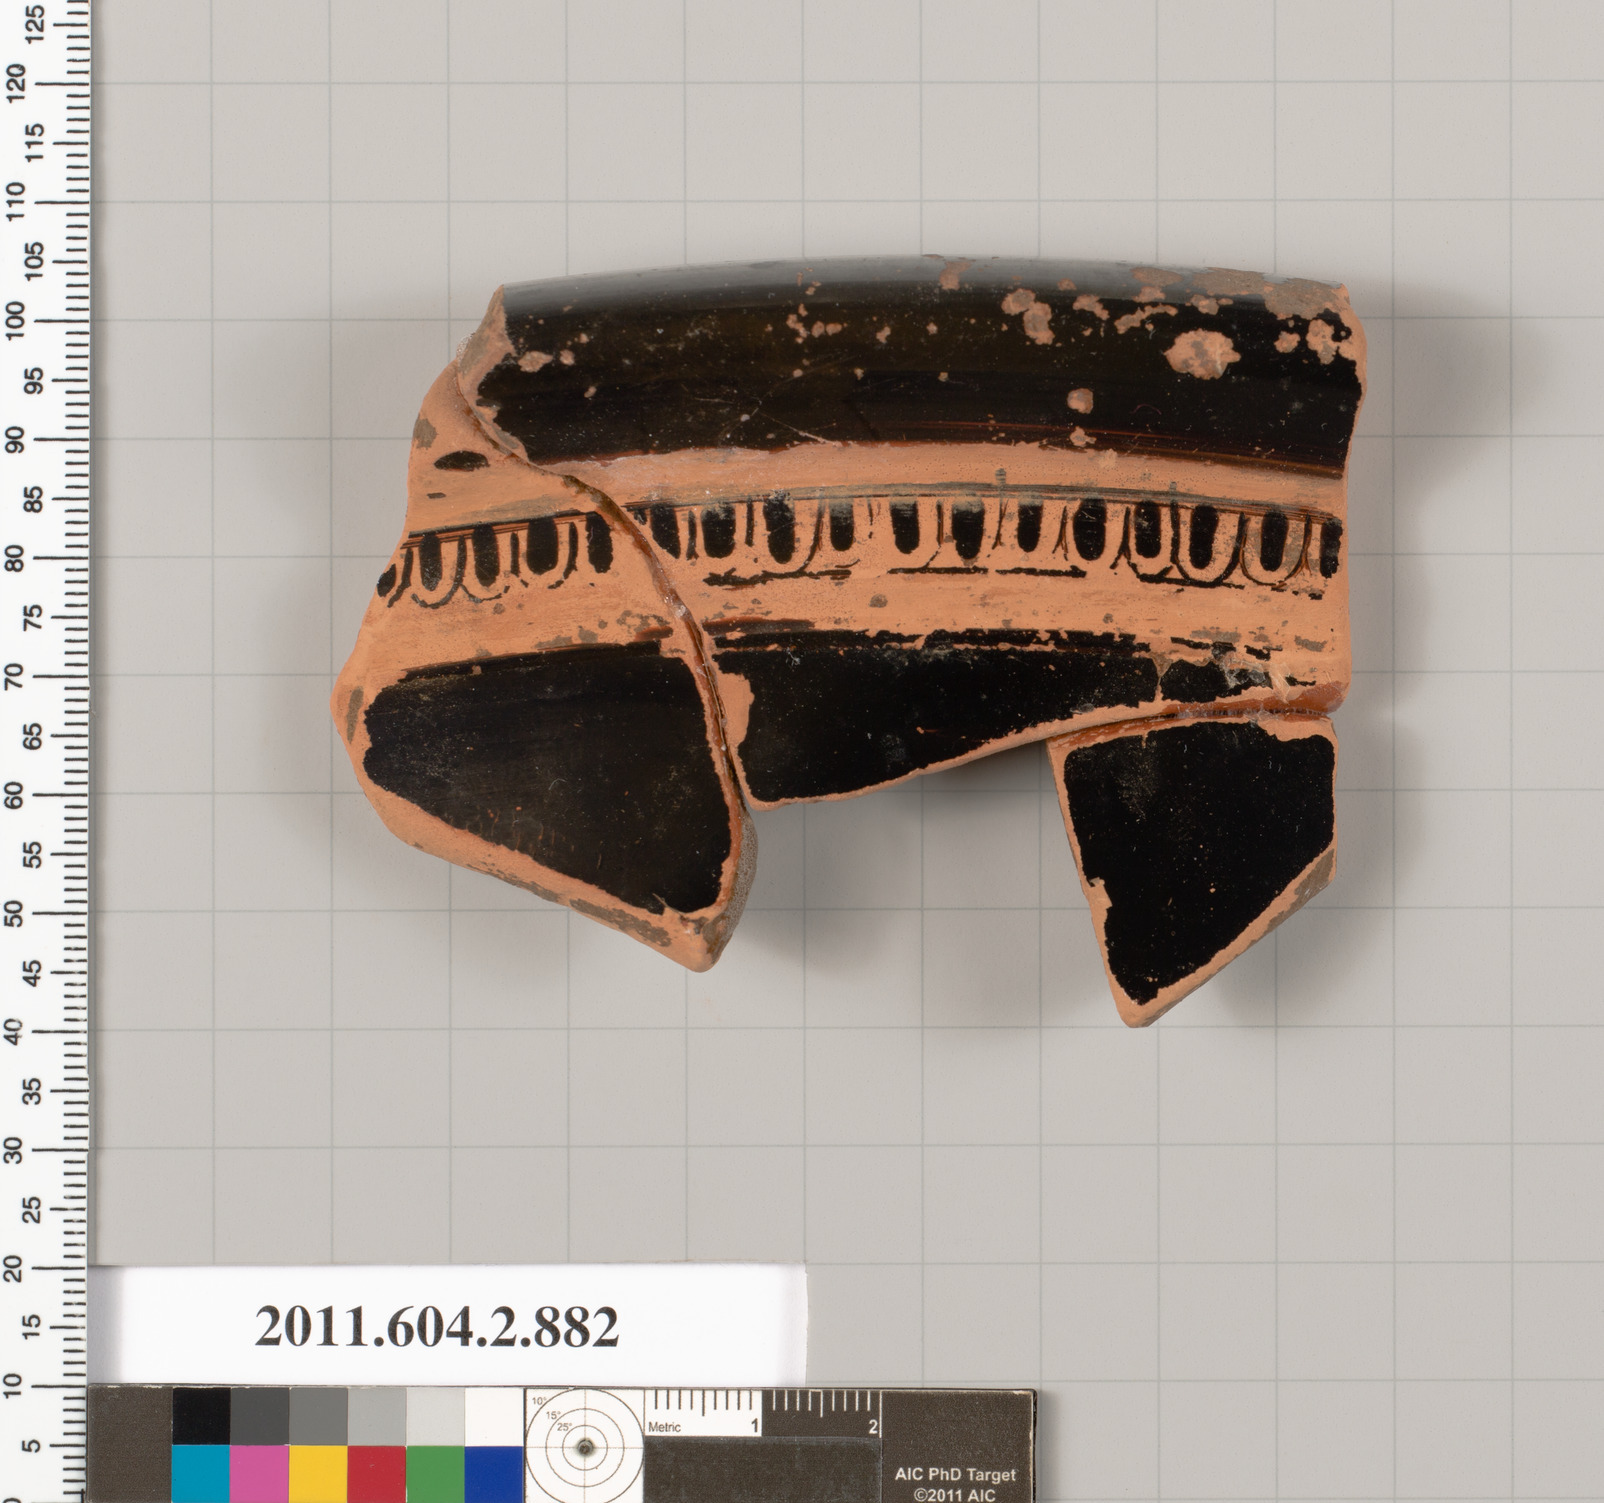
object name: bell krater fragment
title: Terracotta fragment of a bell-krater (bowl for mixing wine and water)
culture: greek, attic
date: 460-450 BCE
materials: terracotta